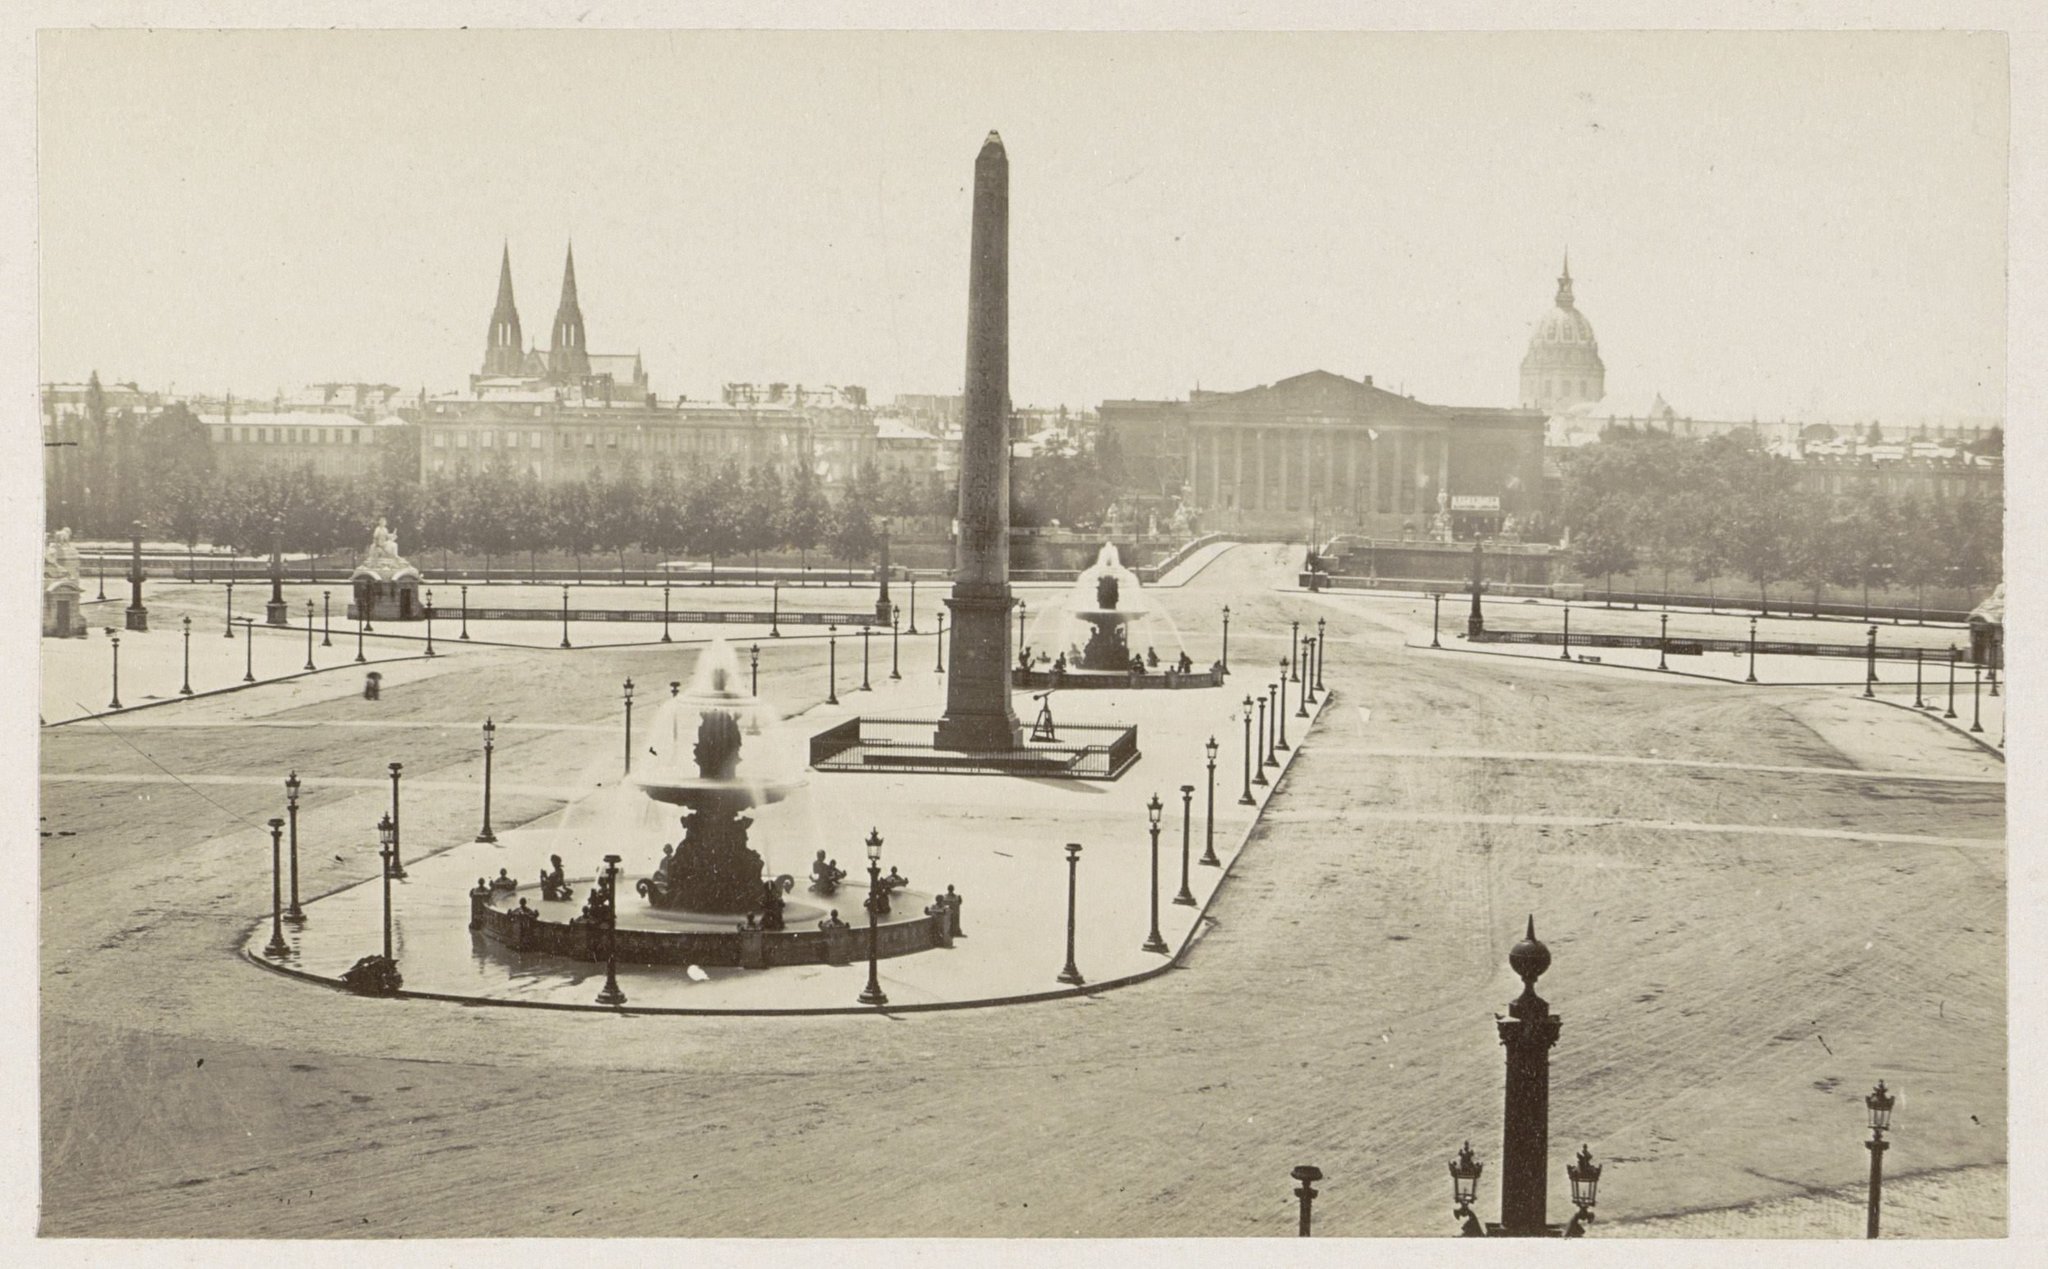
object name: photograph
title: Place de la Concorde in Parijs, in het midden de obelisk van Luxor en fonteinen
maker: Anonymous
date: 1878-1890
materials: photographic support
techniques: albumen print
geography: paris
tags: roman catholic church (+ mary), square, place, circus, etc. (+ city(-scape) with figures, staffage), ornamental fountain (+ city(-scape) with figures, staffage), paris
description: Onderdeel van Reisalbum Europese steden, vermoedelijk Zweeds.